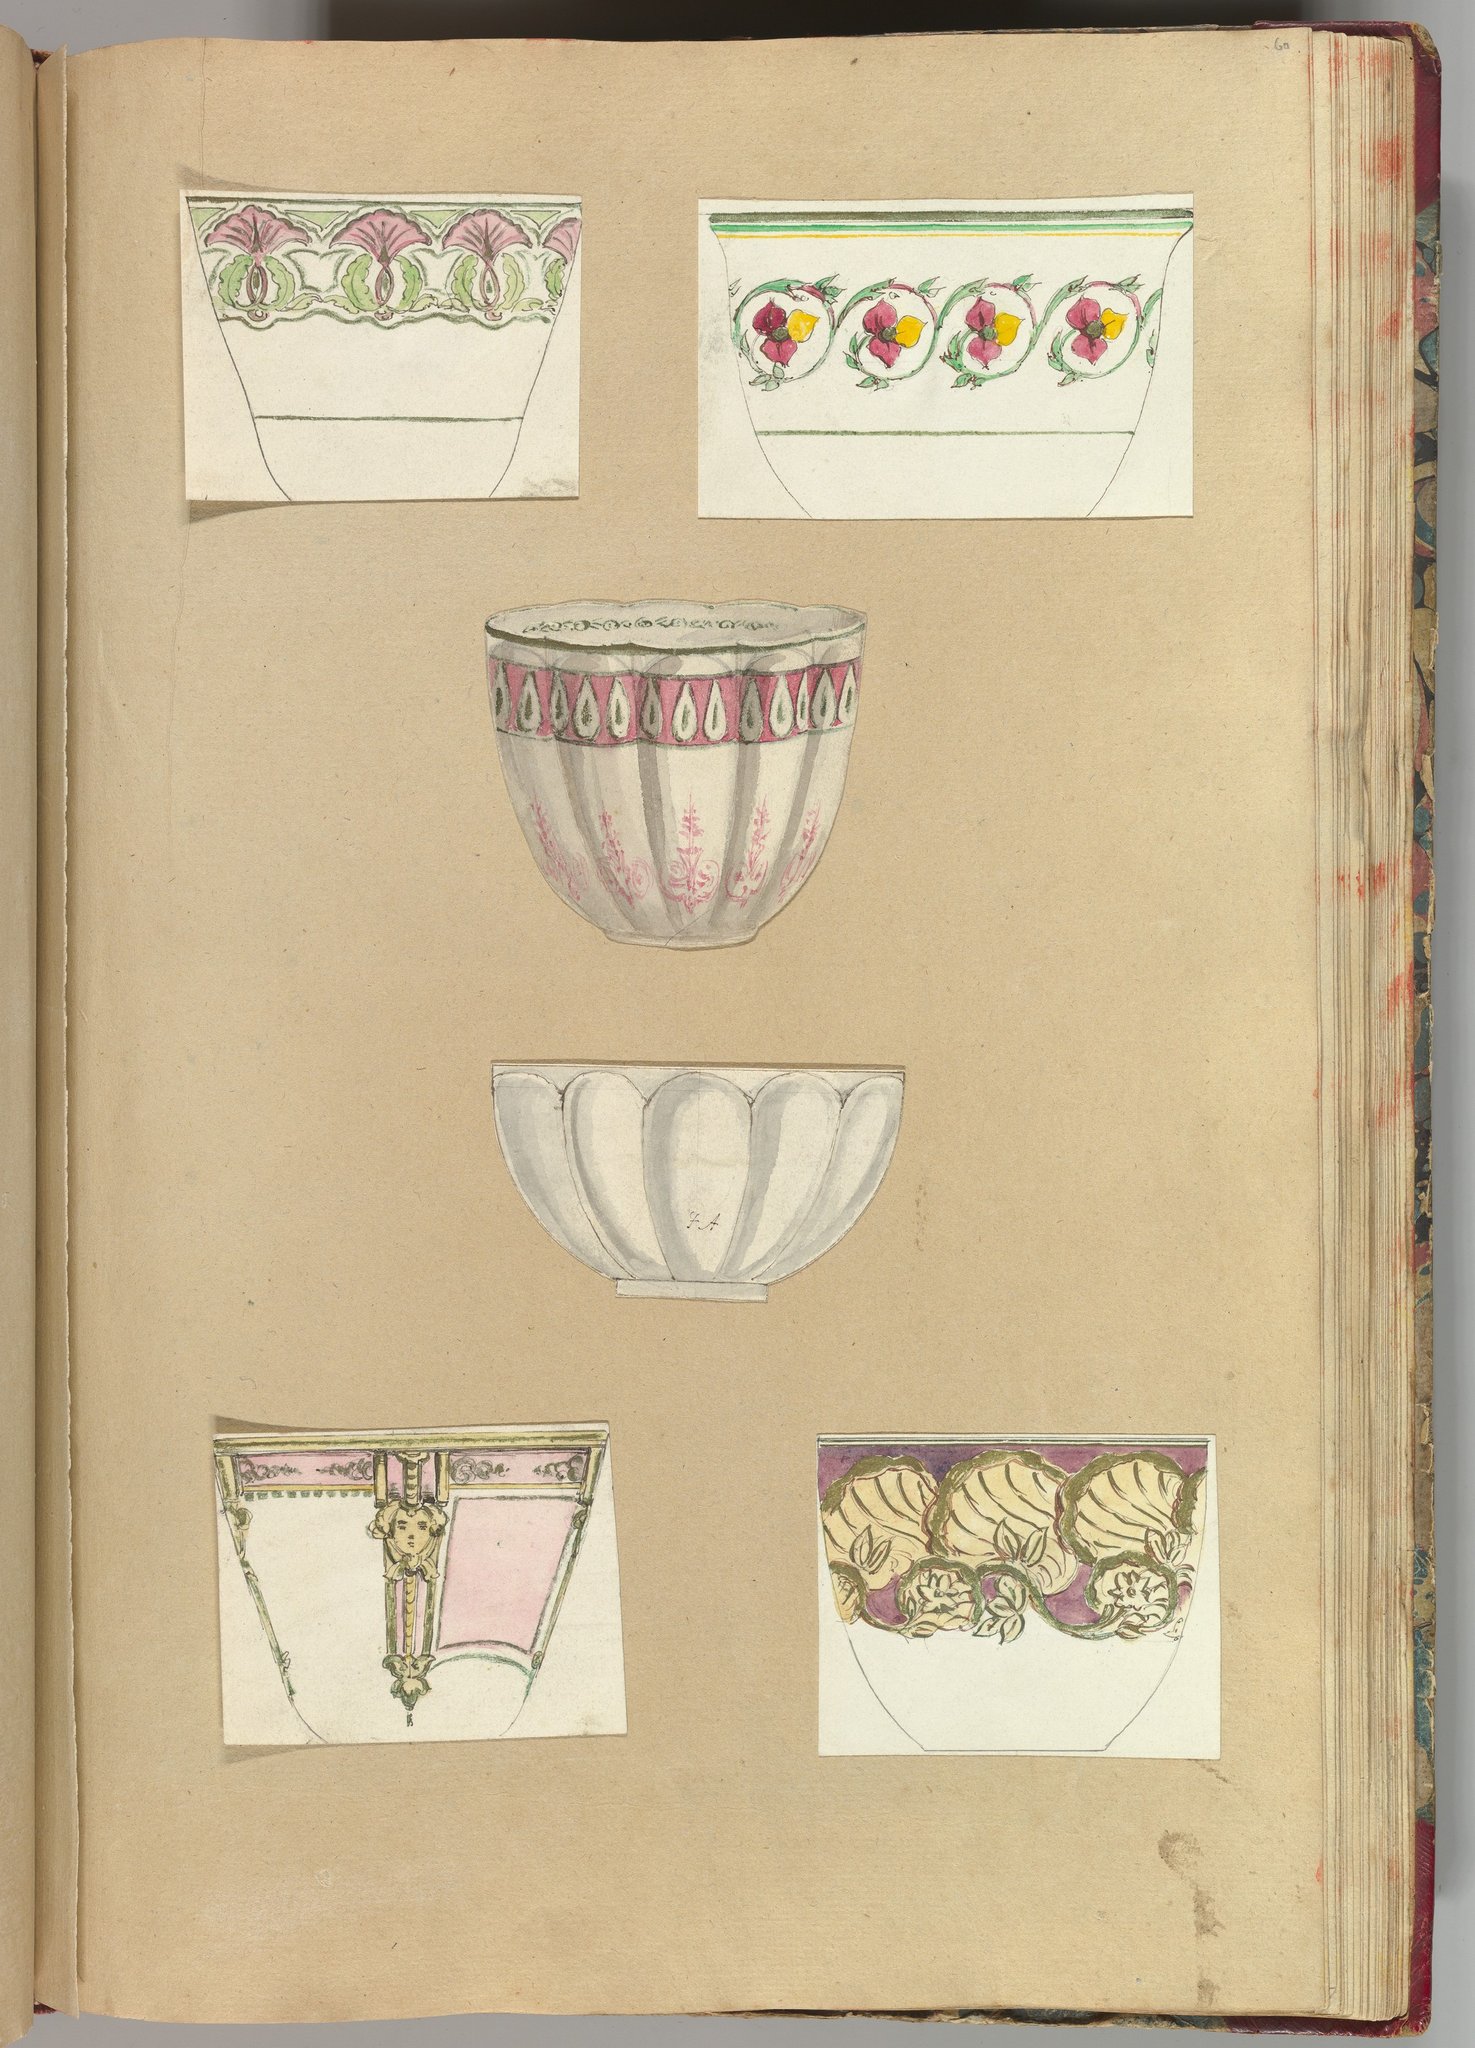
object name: drawing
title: Six Designs for Decorated Cups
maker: alfred henry forrester [alfred crowquill]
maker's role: artist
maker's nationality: british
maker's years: 1804-1872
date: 1845-1855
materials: ink, watercolor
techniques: pen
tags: ornament,cups